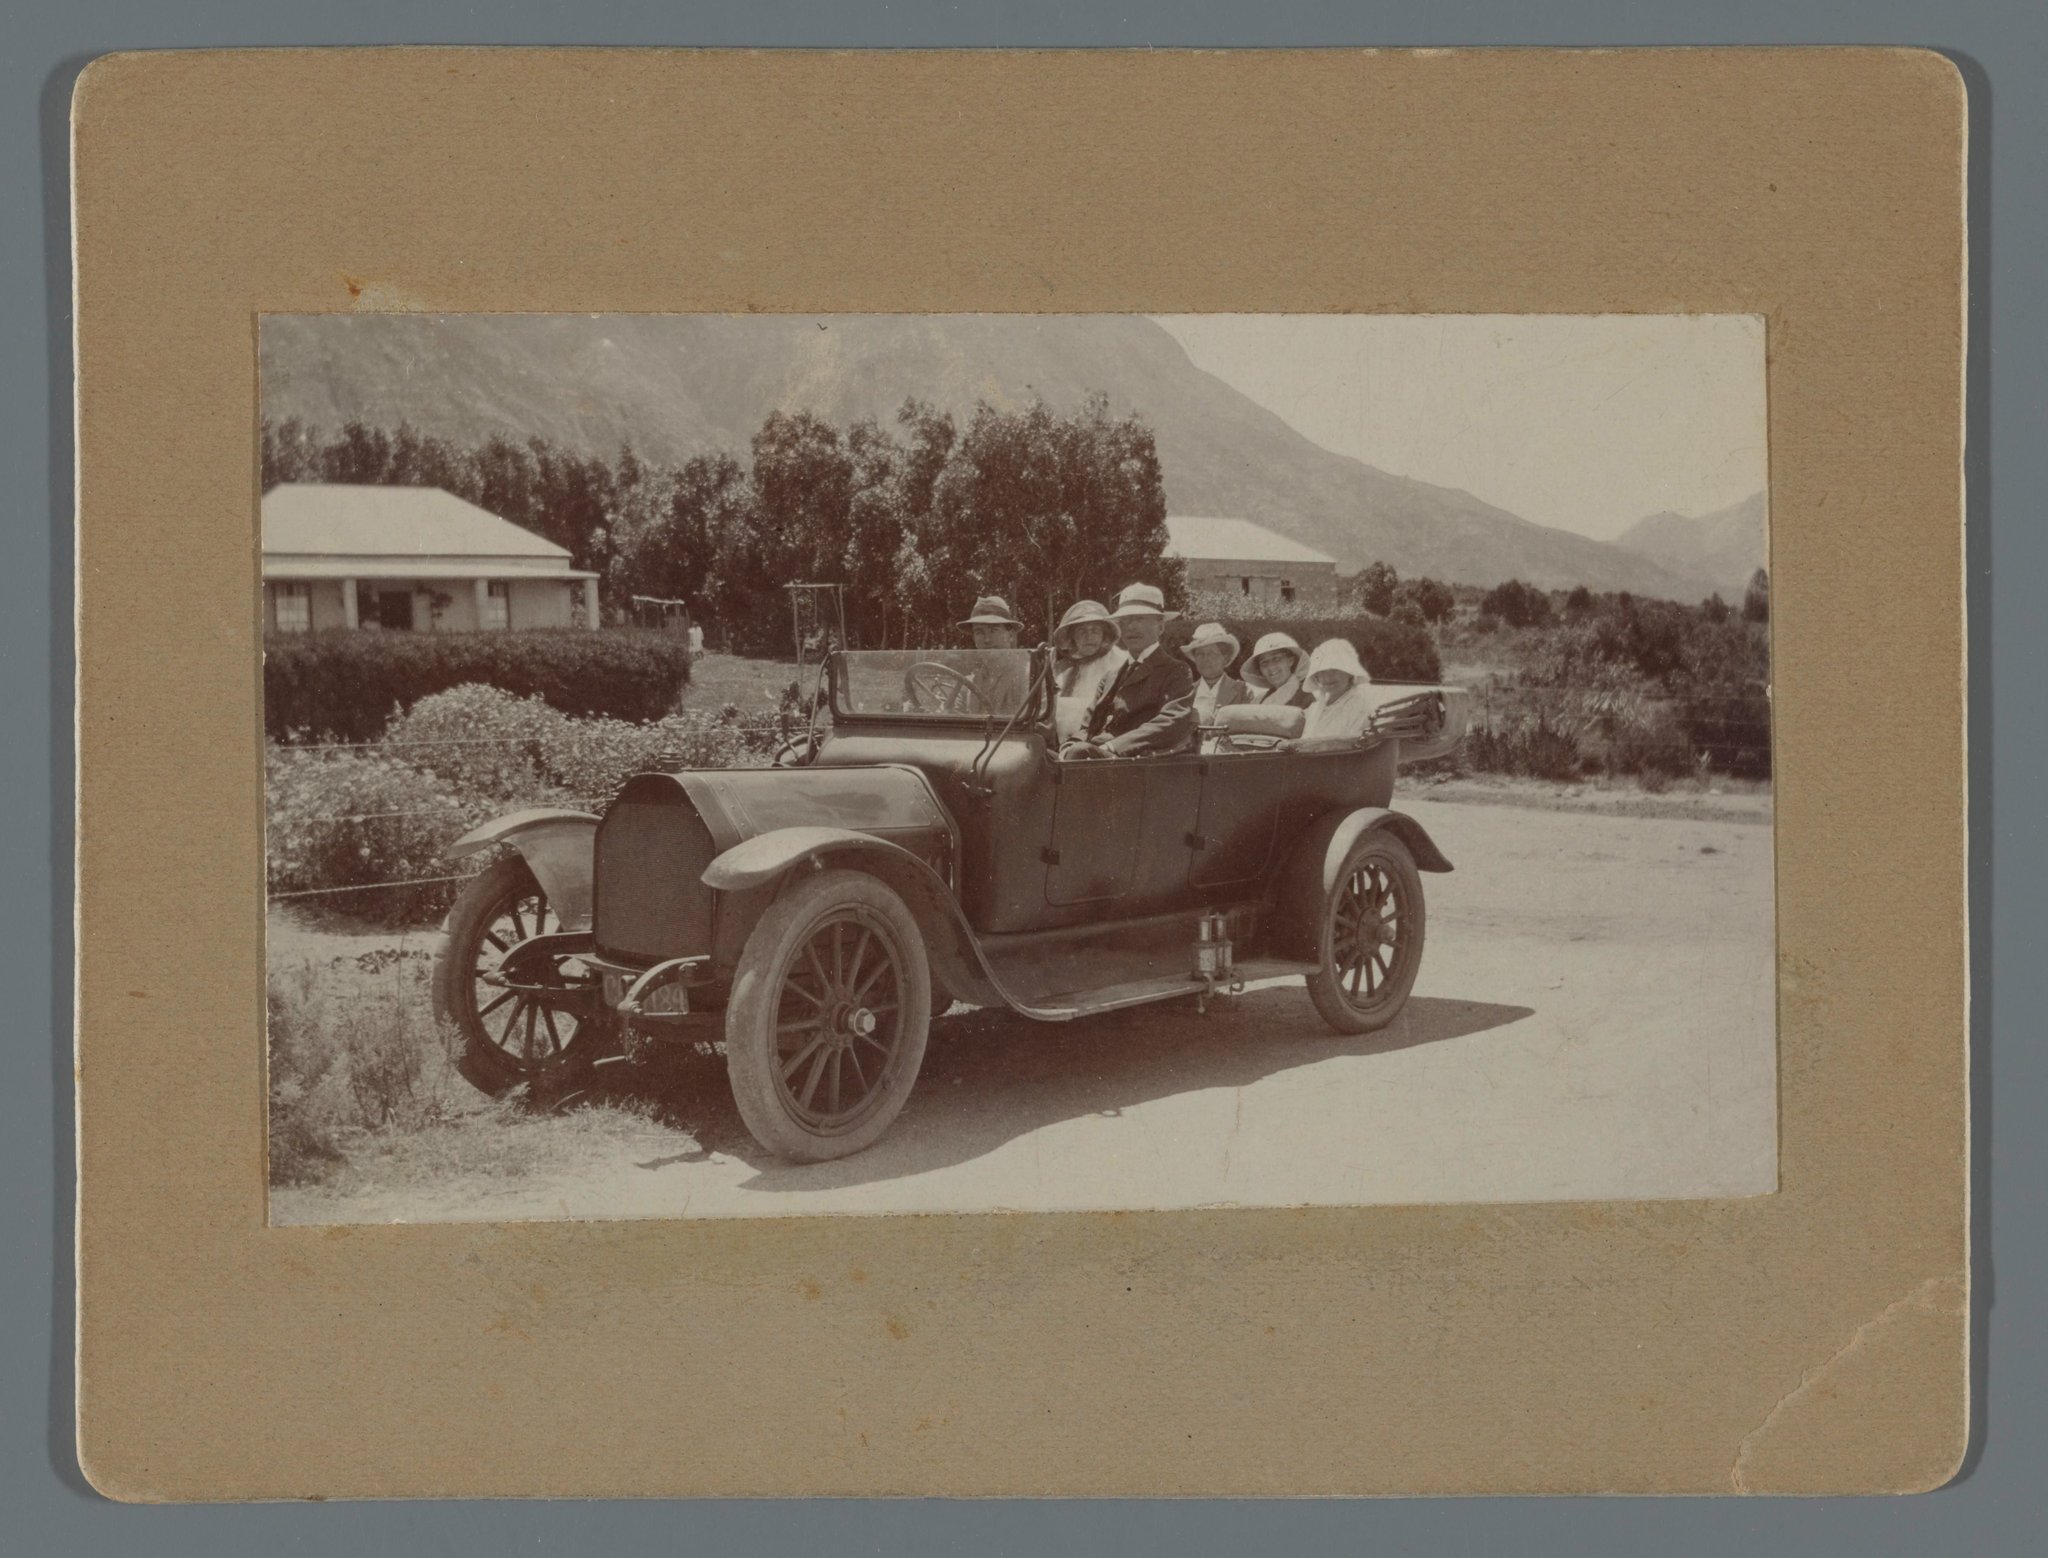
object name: photograph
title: Groepsportret van personen in een auto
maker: cornelia hendrika jonker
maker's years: 1874-1924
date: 1910-1940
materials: cardboard, photographic support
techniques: gelatin silver print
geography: south africa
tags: automobile, anonymous historical persons portrayed in a group, in a group-portrait, mountains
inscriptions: annotation: ‘Z. Afrika’